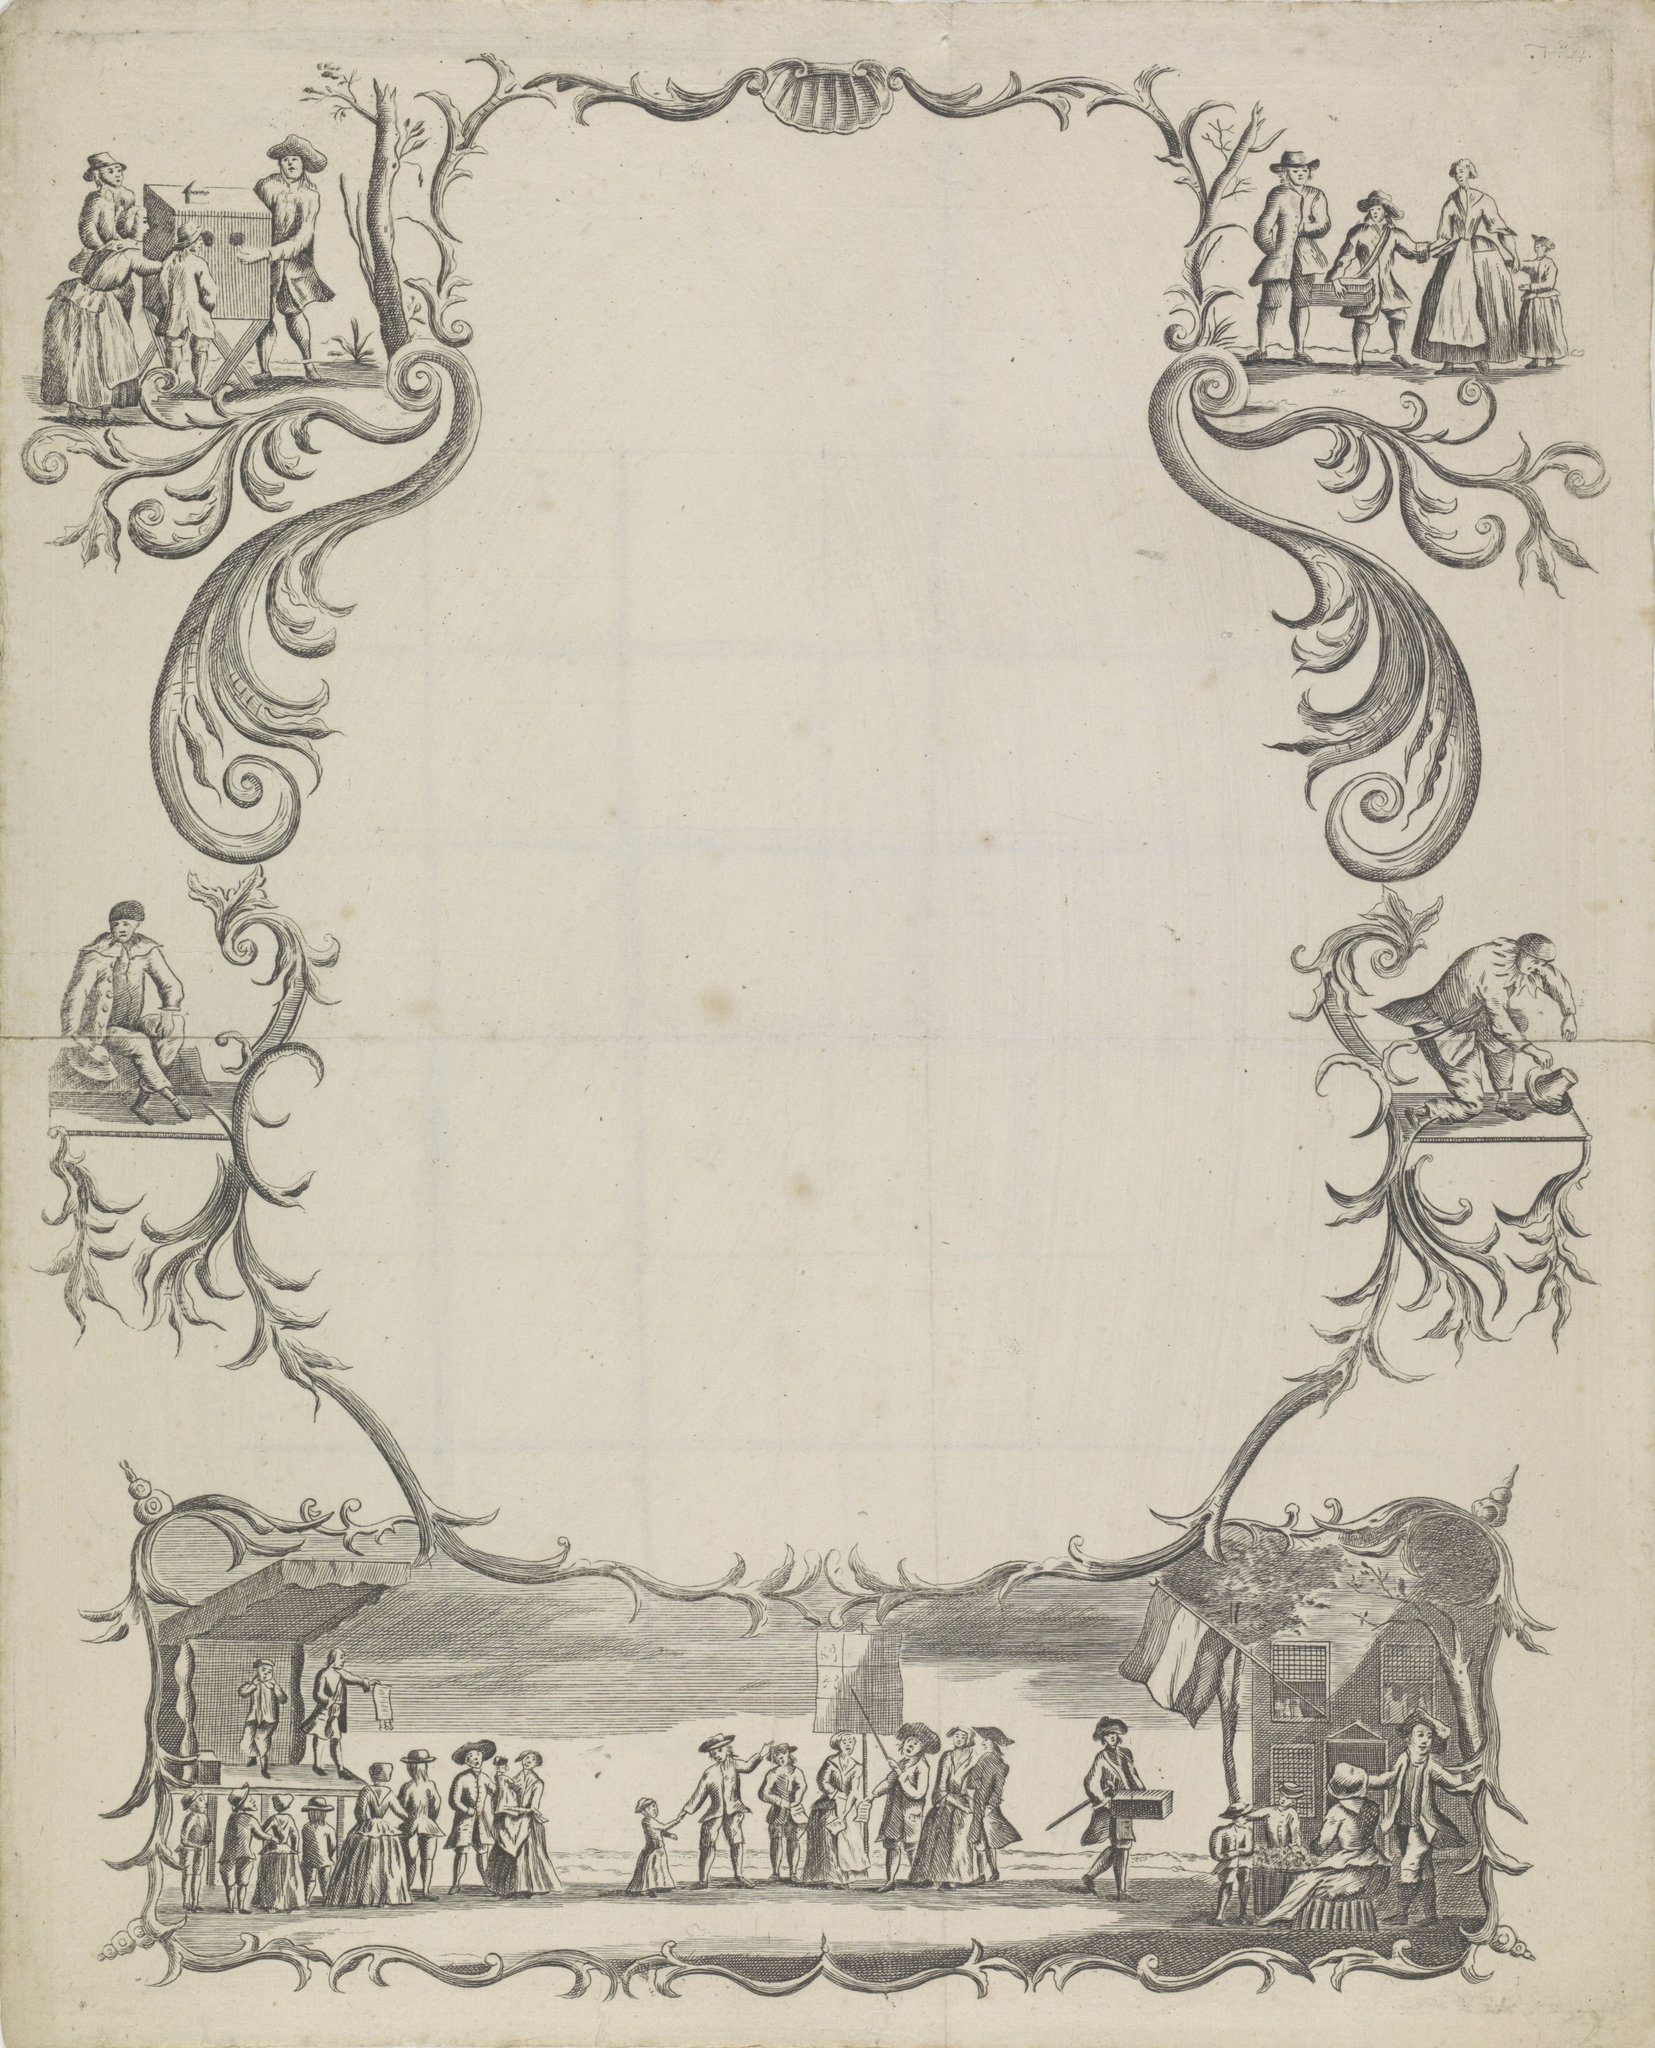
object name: wensbrief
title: Wensbrief met decoratief kader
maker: Anonymous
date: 1700-1899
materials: paper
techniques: etching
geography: netherlands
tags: pleasure fair and circus, peep-show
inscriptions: collector's mark: Lugt 2760, collector's mark: Lugt 2228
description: Wensbrief met onbeschreven cartouche binnen een decoratief kader met voorstellingen van een rarekiek, een echtpaar met kinderen en een kermistafereel. Op verso een raster in potlood.